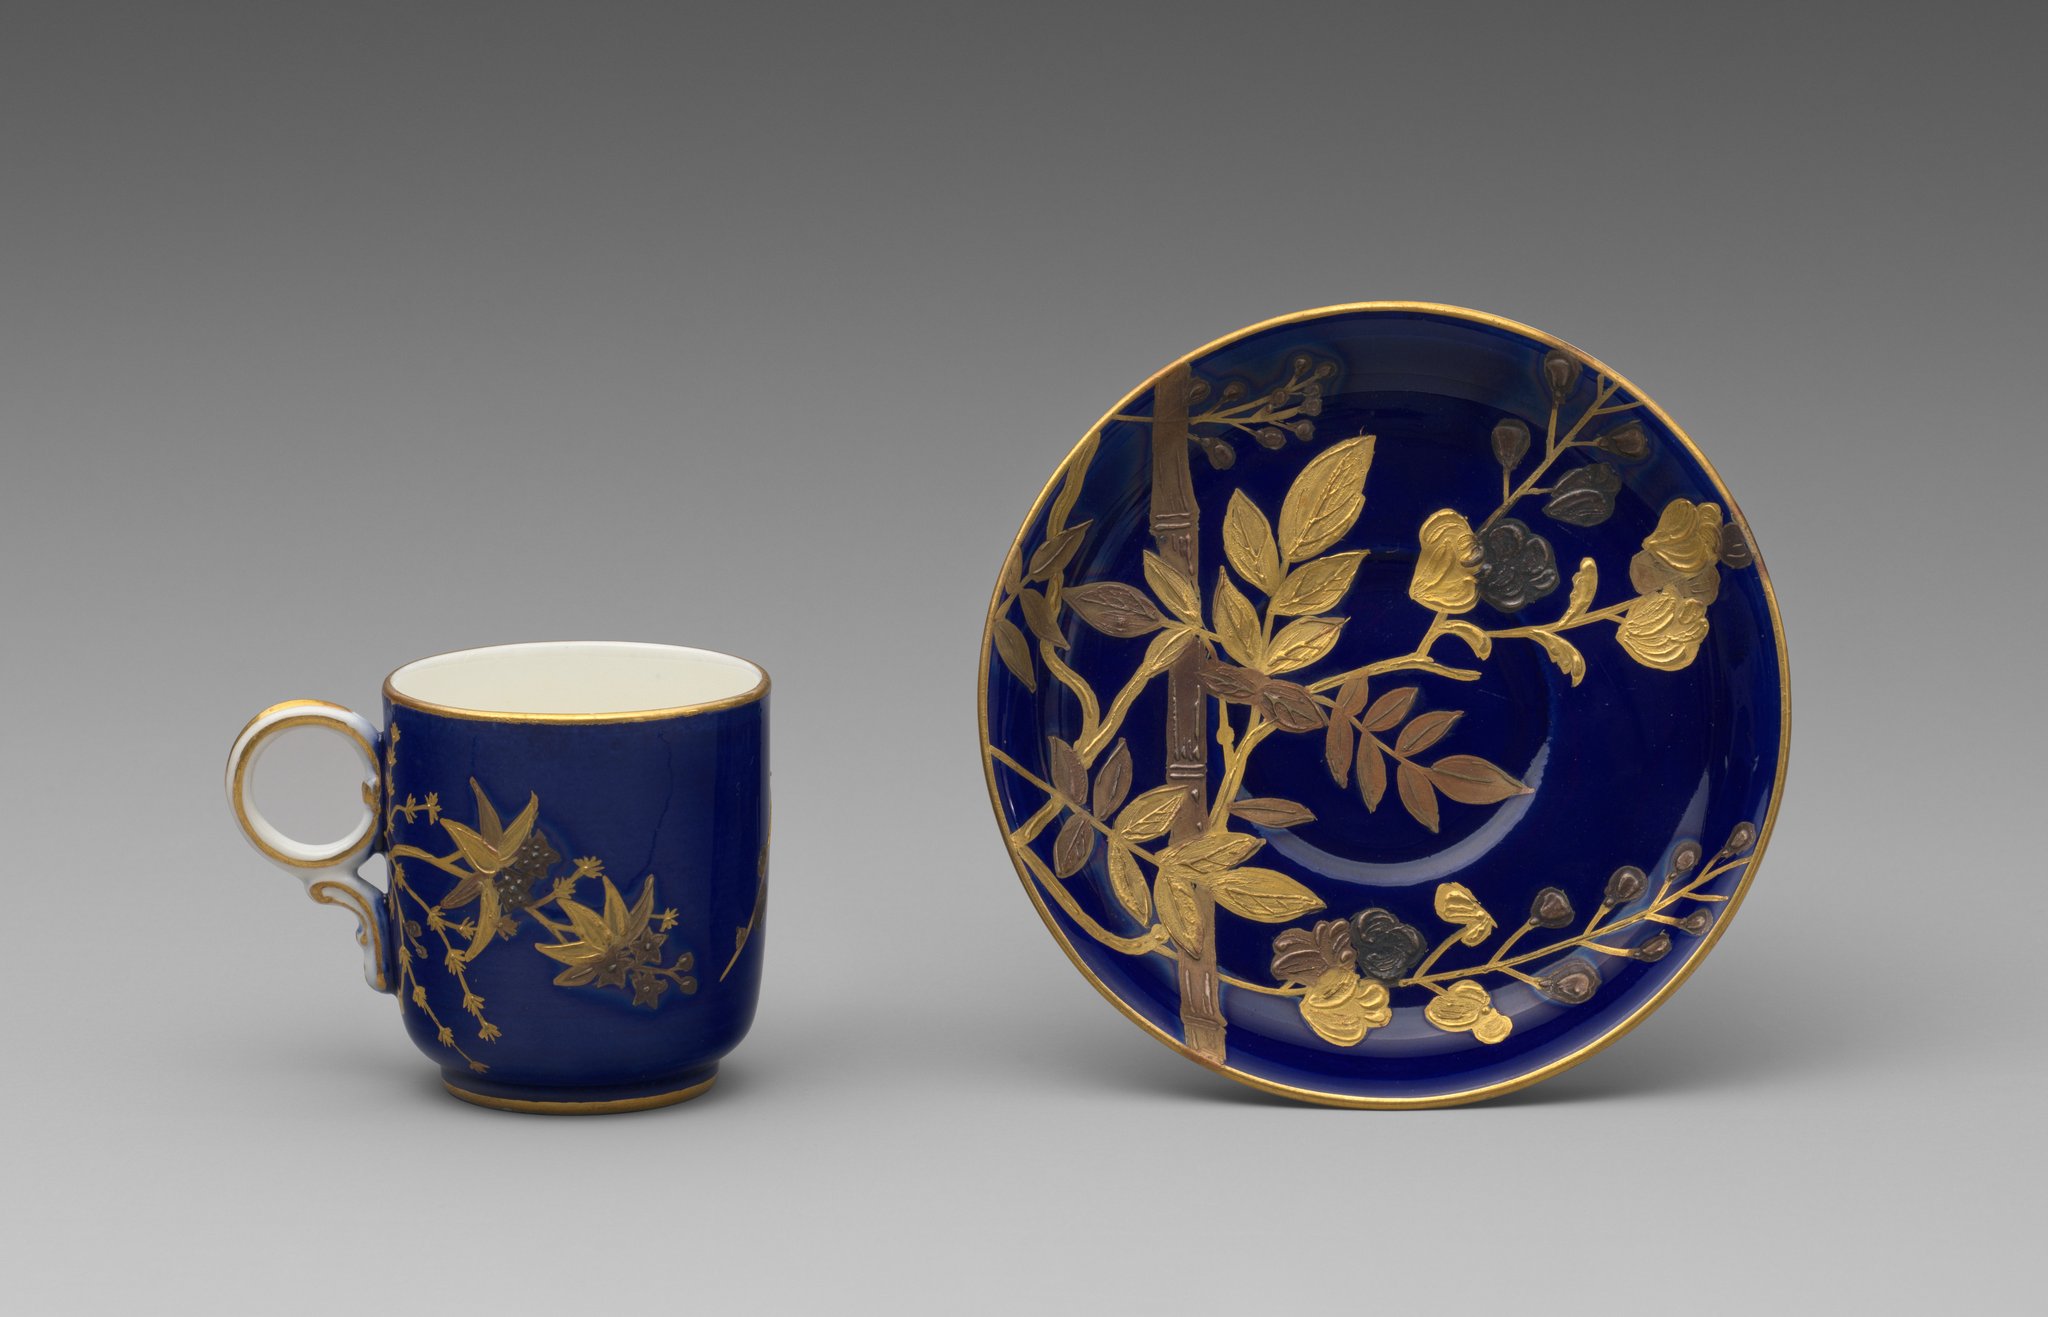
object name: cup and saucer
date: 1895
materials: hard paste porcelain